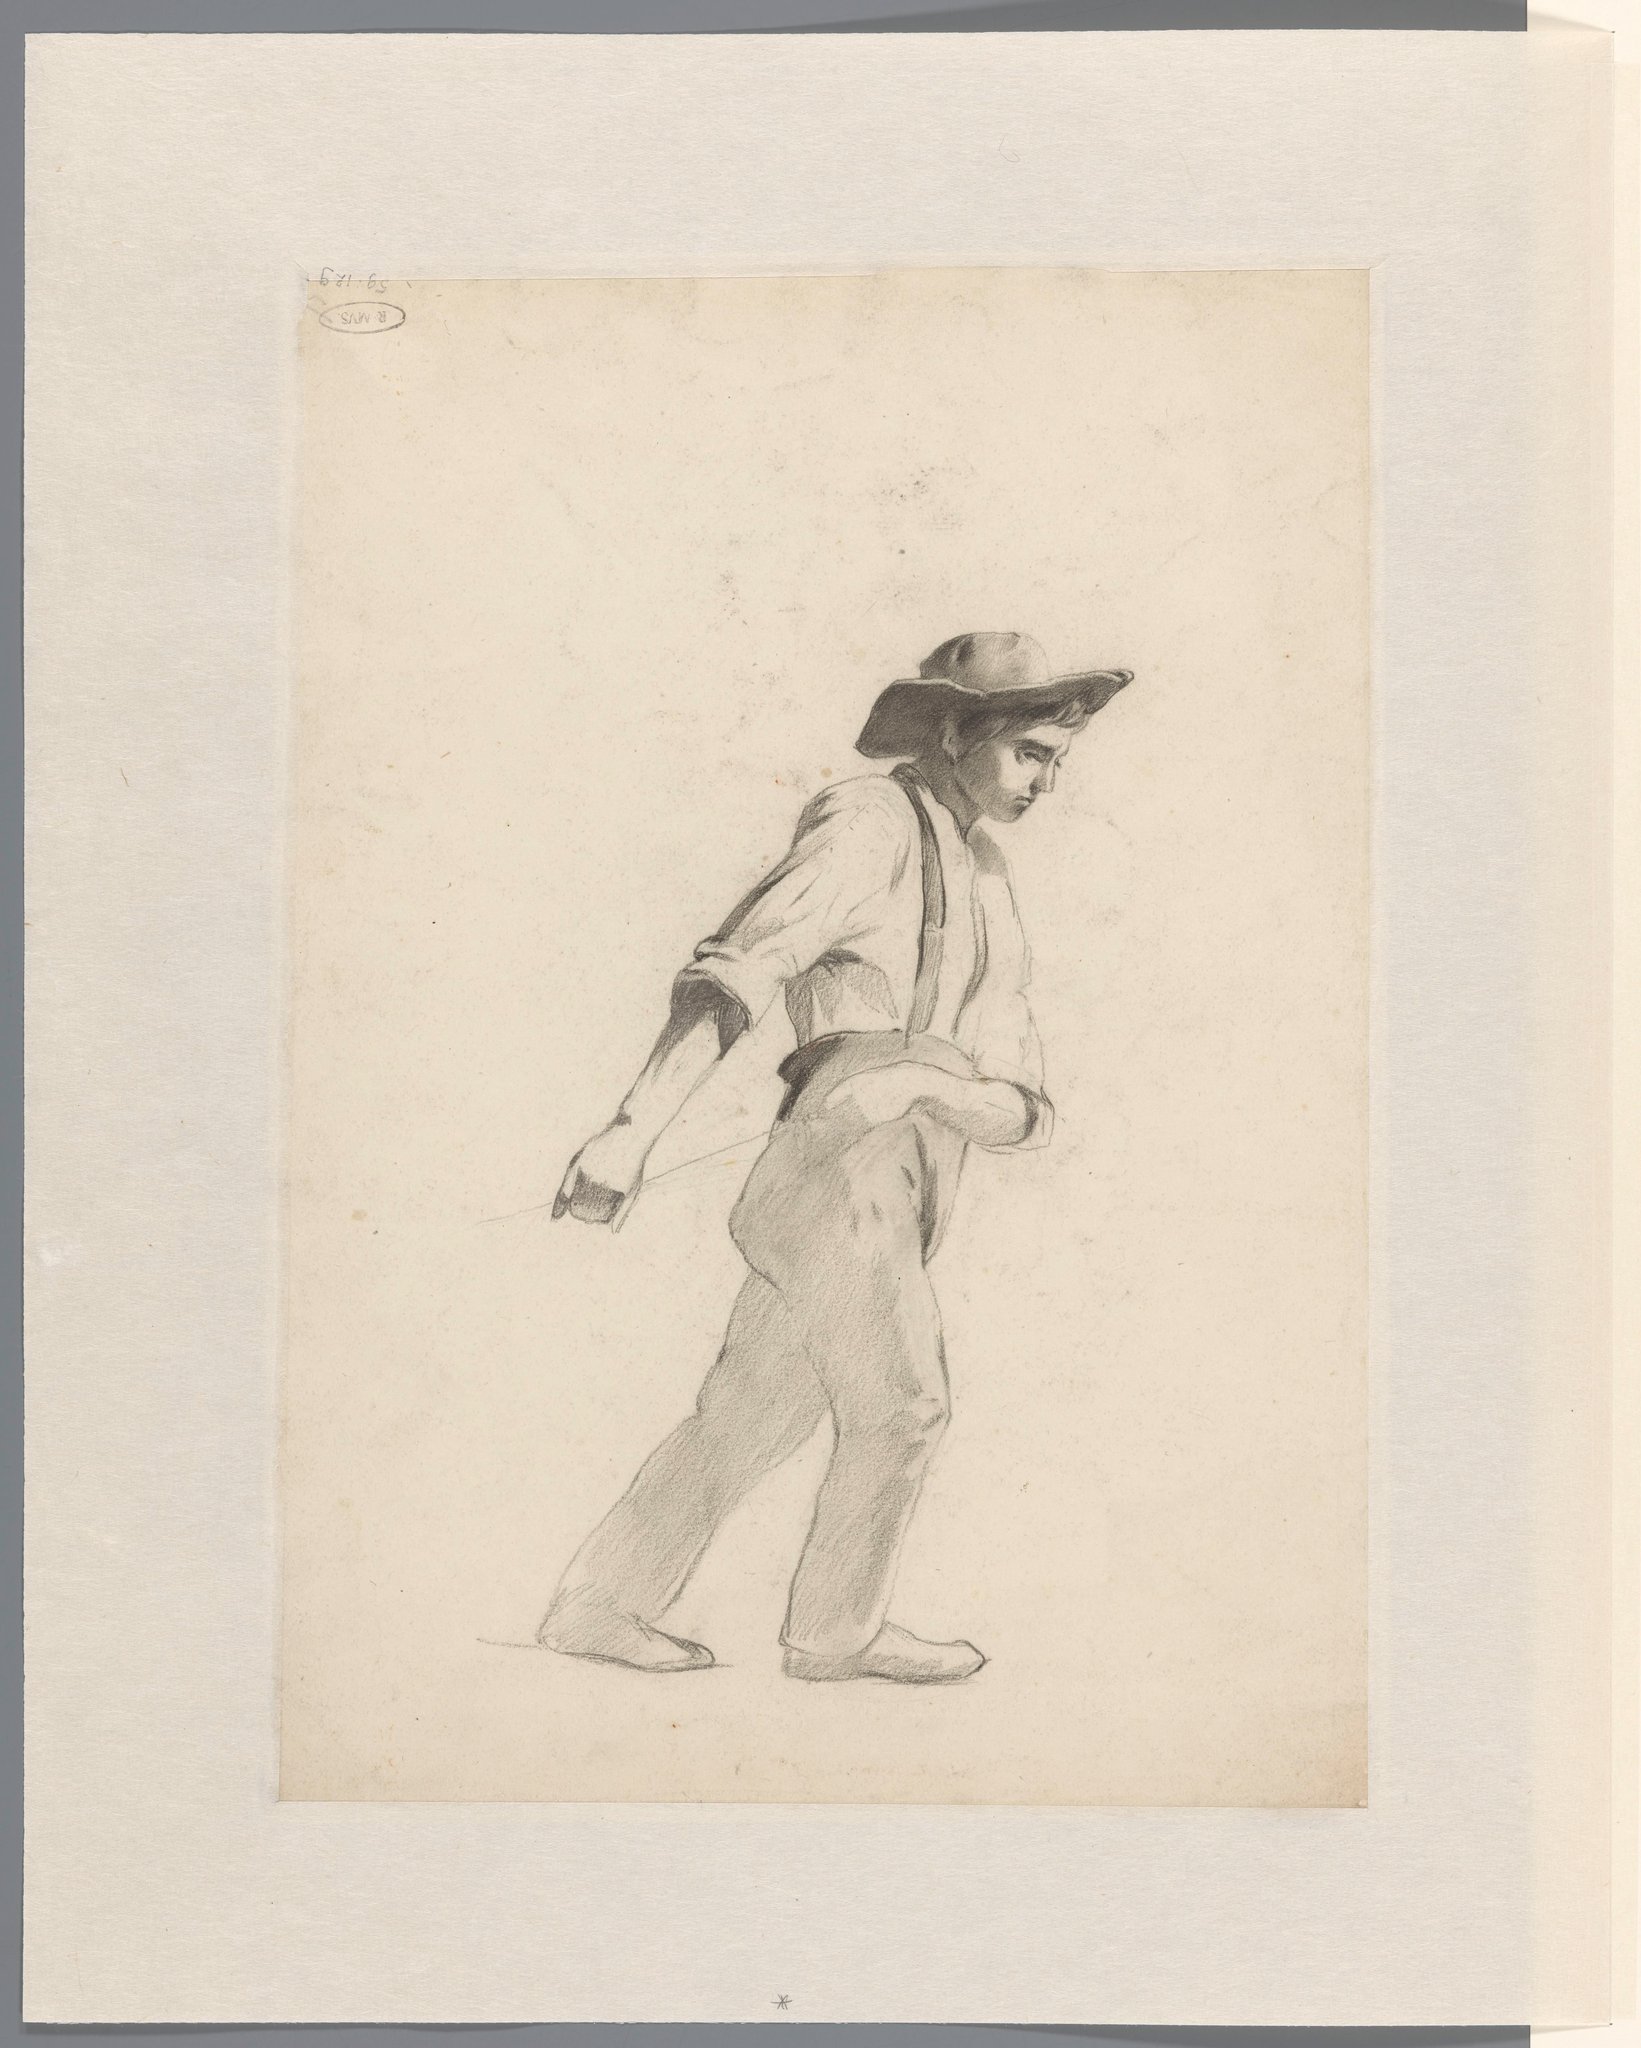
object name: drawing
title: Jongen die een last trekt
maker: anton mauve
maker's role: draughtsman, painter, print maker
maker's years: 1838-1888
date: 1848-1888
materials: chalk, paper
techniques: brush